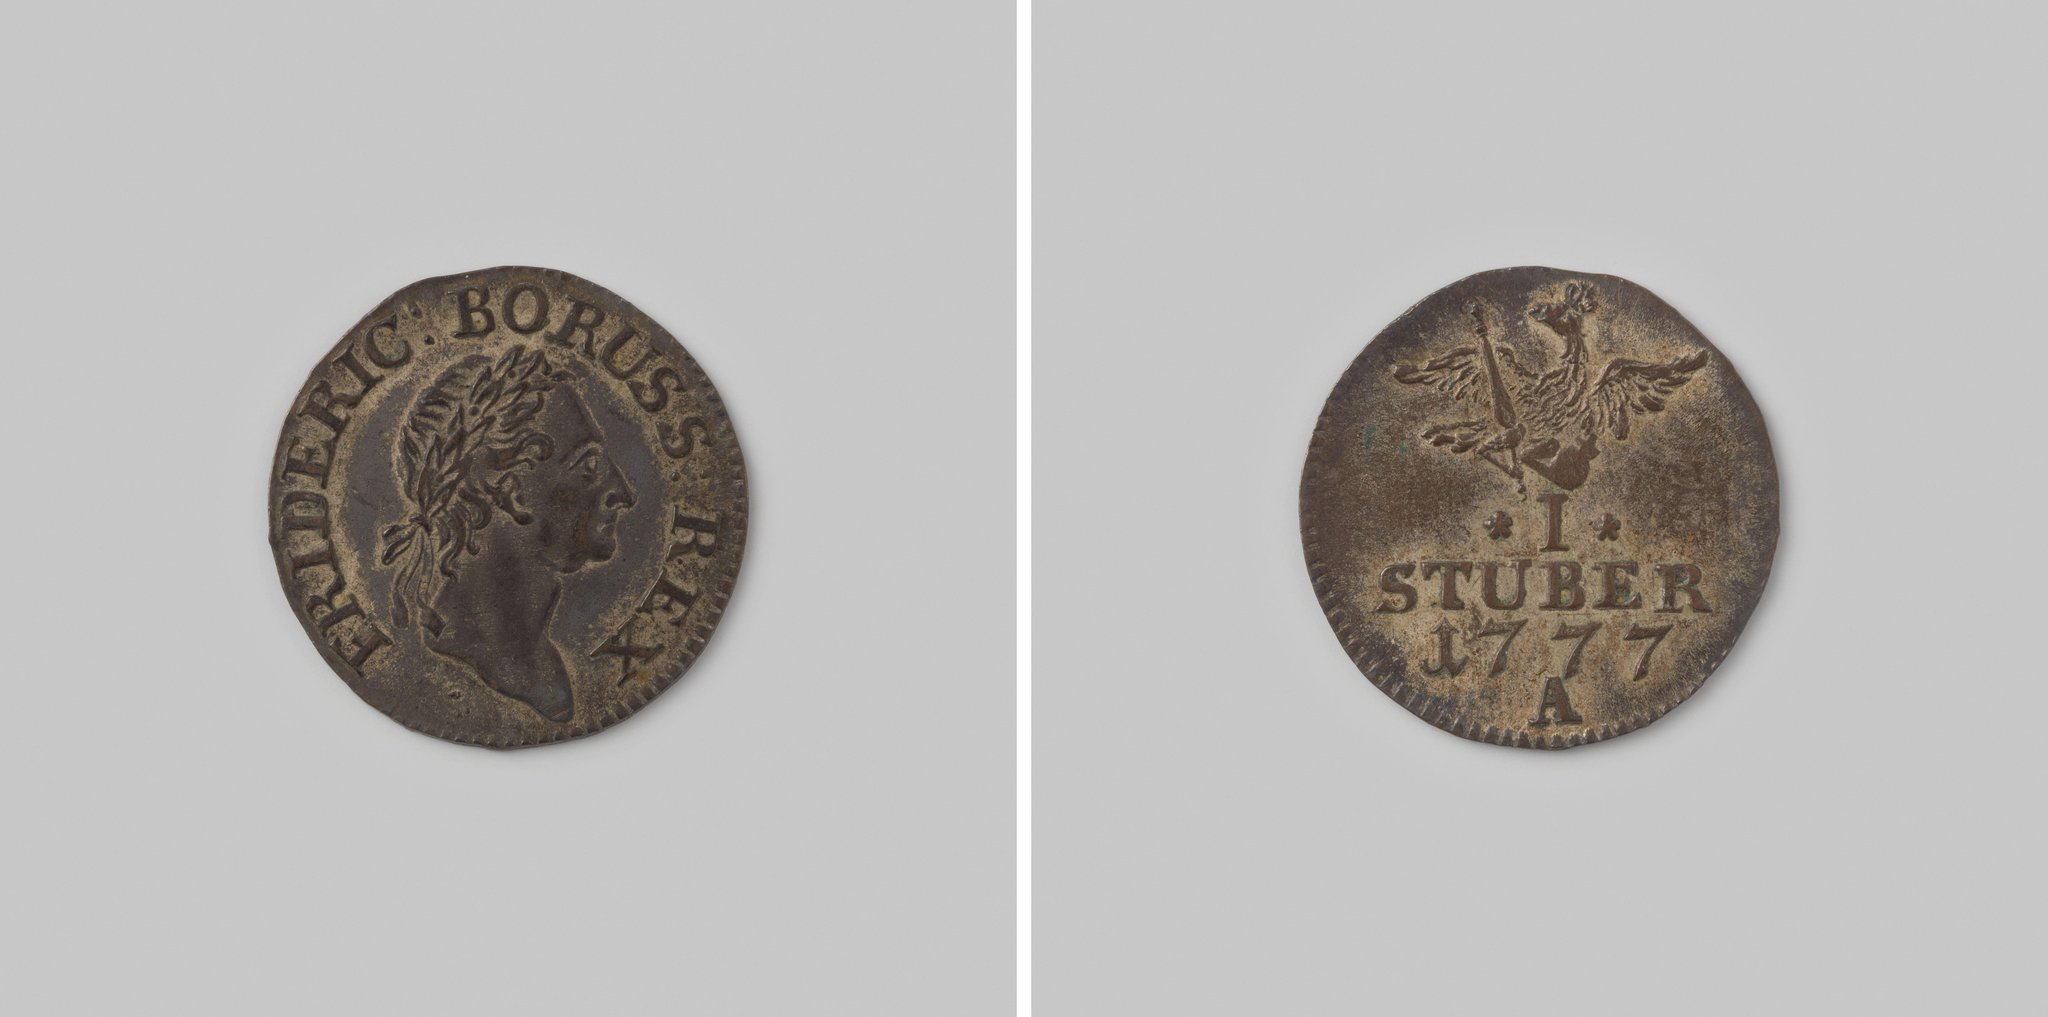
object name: coin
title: Oost-Friesland, koning Friedrich II van Pruisen, Stüber, 1777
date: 1777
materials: silver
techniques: striking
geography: berlin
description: Zilveren munt. Voorzijde: hoofd van de koning naar rechts. Keerzijde: gekroonde adelaar met scepter en rijksappel. Daaronder waarde-aanduidingin twee regels, waaronder jaartal. Letter A {=Berlijn] onderaan. Gladde rand.